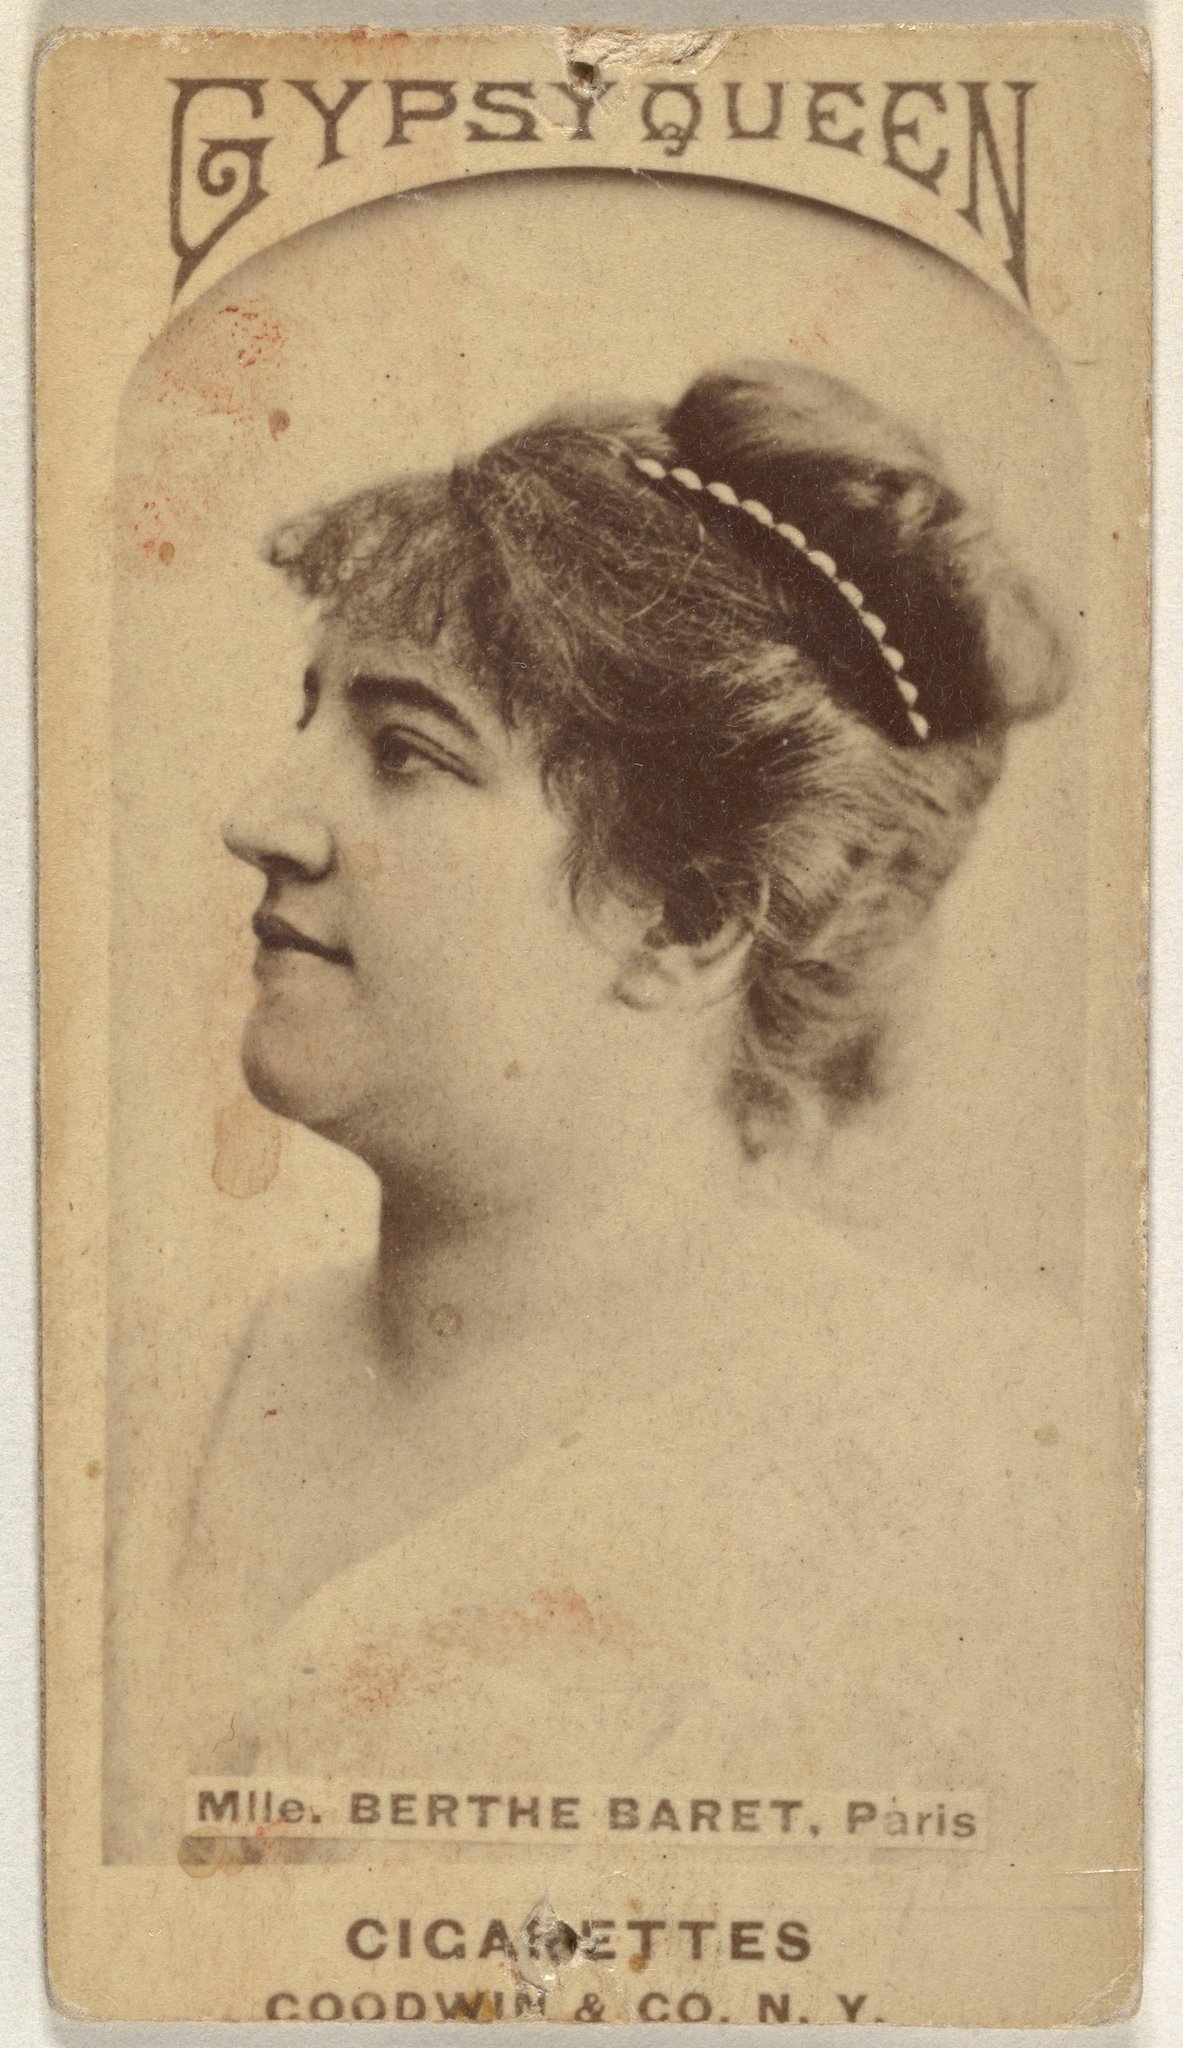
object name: photograph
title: Mlle. Berthe Baret, Paris, from the Actors and Actresses series (N171) for Gypsy Queen Cigarettes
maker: goodwin & company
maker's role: publisher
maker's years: 1850-1950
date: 1886-1890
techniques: albumen silver print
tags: portraits,women,actresses